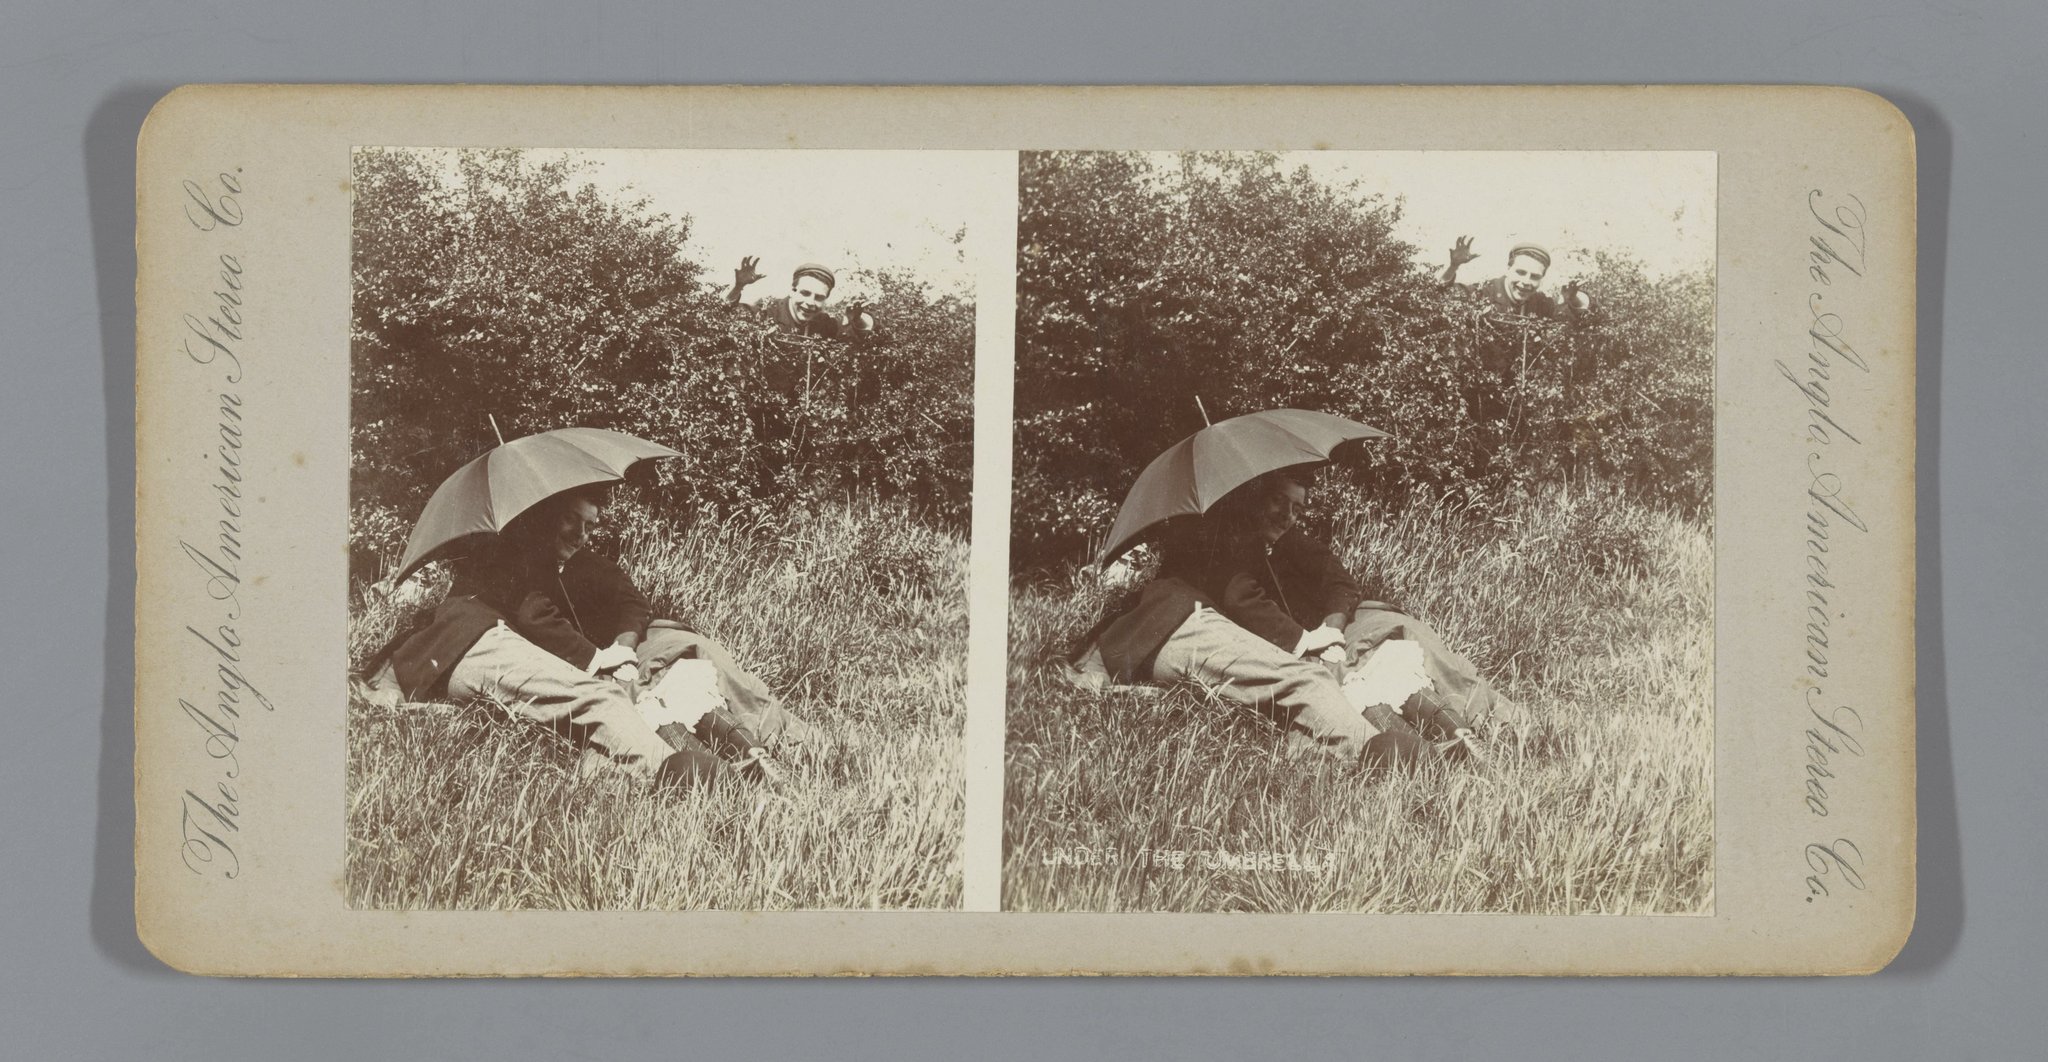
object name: stereograph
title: Under the Umbrella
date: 1880-1910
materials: cardboard, photographic support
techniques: gelatin silver print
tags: umbrella, couple of lovers